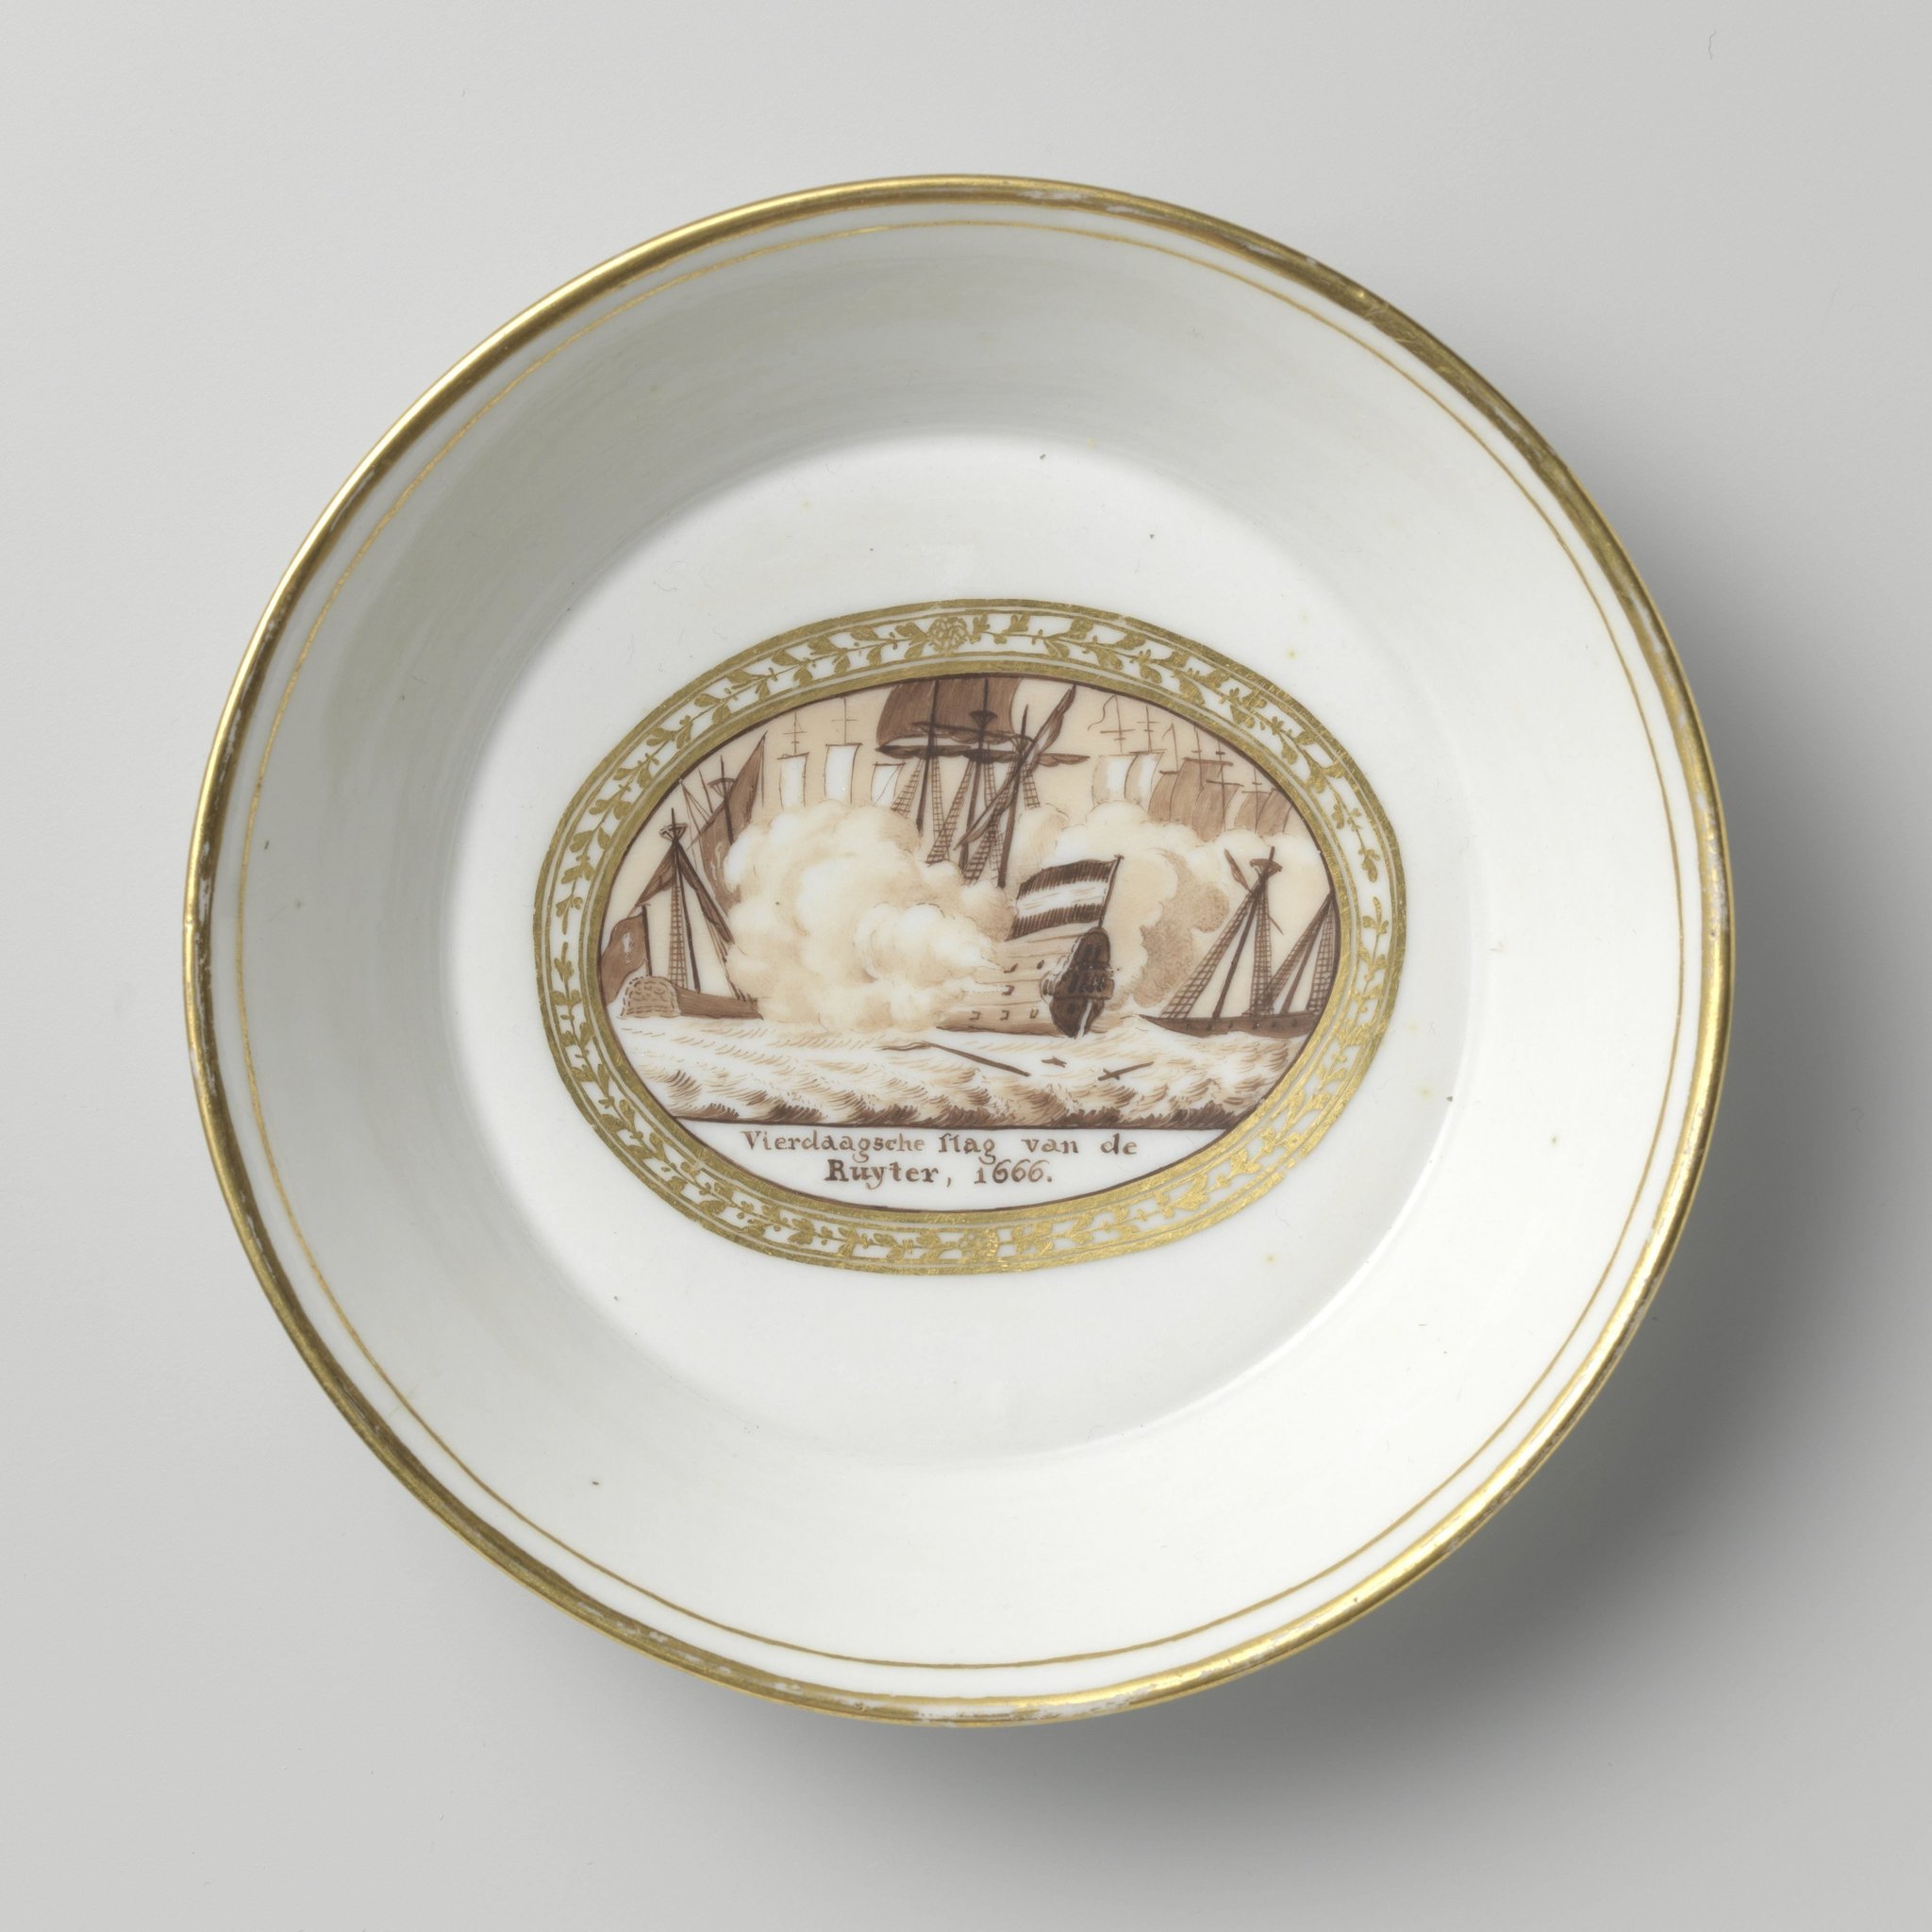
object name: platter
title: Saucer with an image of the Four Days' Battle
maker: Anonymous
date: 1794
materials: glaze, paint, porcelain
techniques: firing, forming, gilding, turning, vitrification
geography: schwarzburg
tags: flushing, michiel adriaenszoon de ruyter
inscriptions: inscription: ‘VIERDAAGSE SLAG VAN DE RUYTER, 1666’, mark: ‘103-N/ 15’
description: Schotel,één van een serie van tien,onderdeel van een servies met in bruin geschilderde medaillons waarin historische voorvallen en portretten van personen uit de vaderlandse geschiedenis. Schotel is gedecoreerd met een voorstelling van de vierdaagse slag van Michiel Adriaansz. de Ruyter in 1666. Gemerkt.